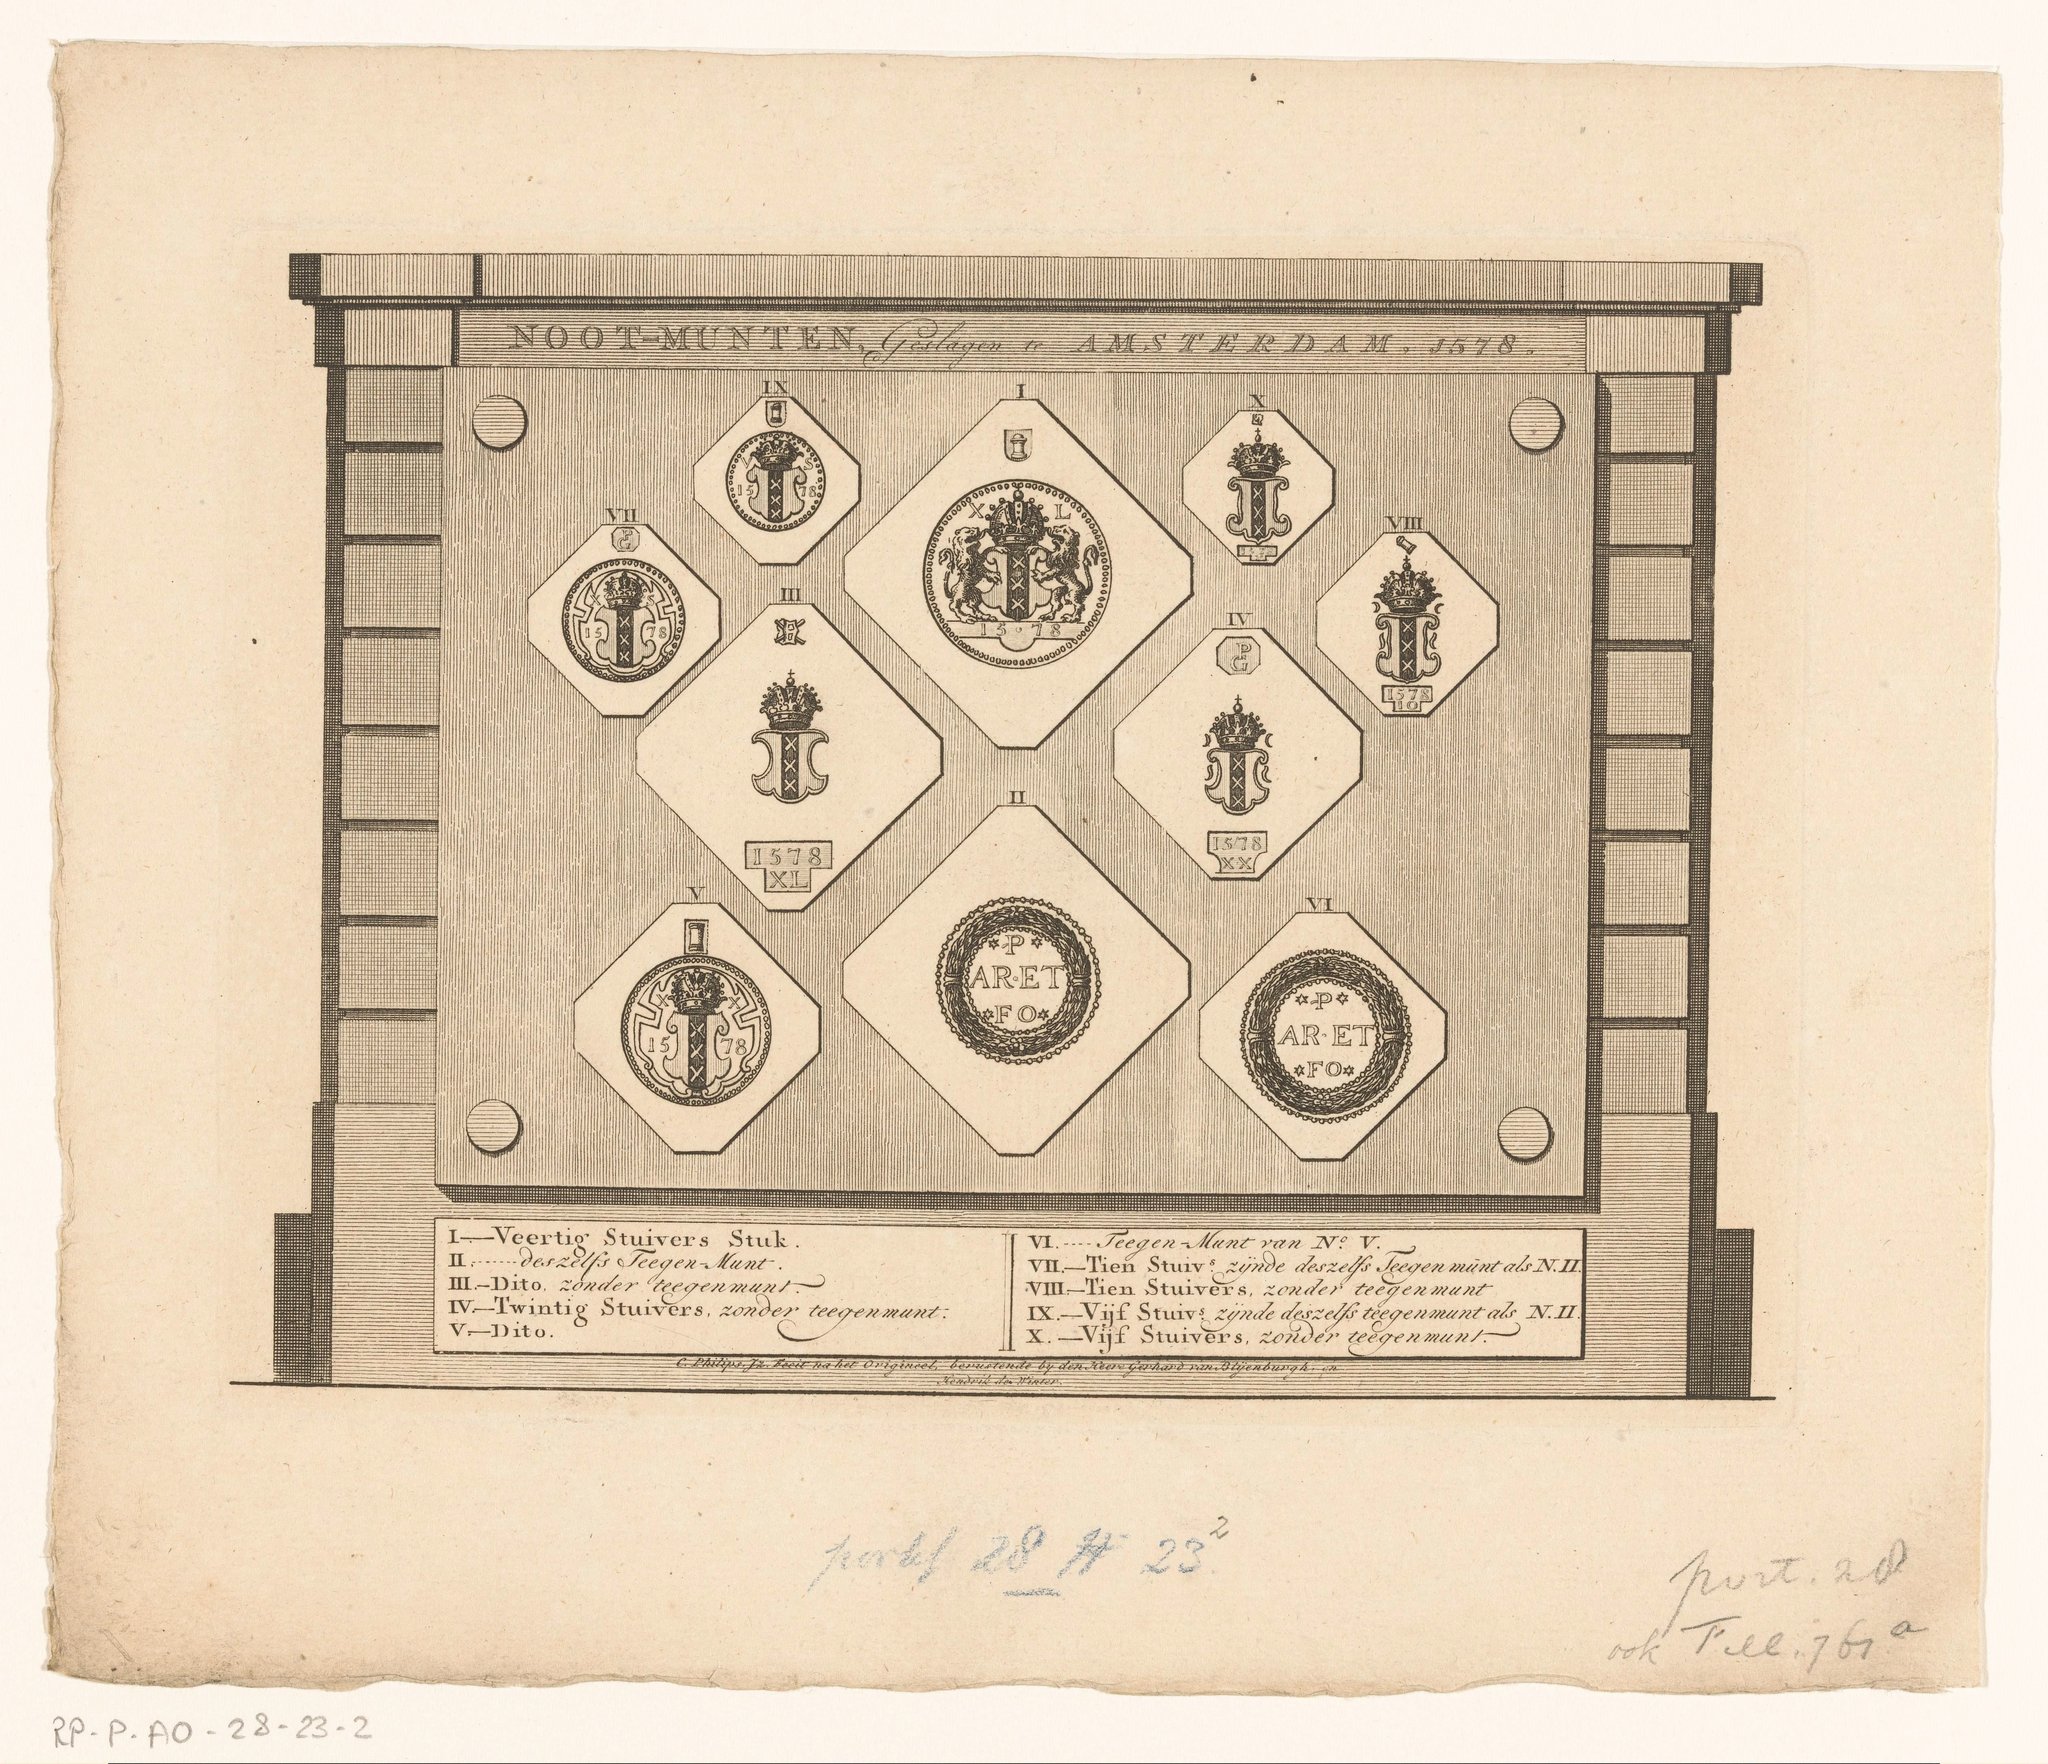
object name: print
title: Noot-munten, geslagen te Amsterdam, 1578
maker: caspar jacobsz. philips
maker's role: draughtsman, print maker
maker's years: 1732-1789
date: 1752-1789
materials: paper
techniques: engraving, etching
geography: amsterdam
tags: coin, amsterdam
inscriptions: collector's mark: Lugt 2228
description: Volgens Muller gebruikt als illustratie in Wagenaars geschiedenis van Amsterdam. Dit lijkt niet te kloppen. Voor eerste bekende staat zie RP-P-OB-79.747.